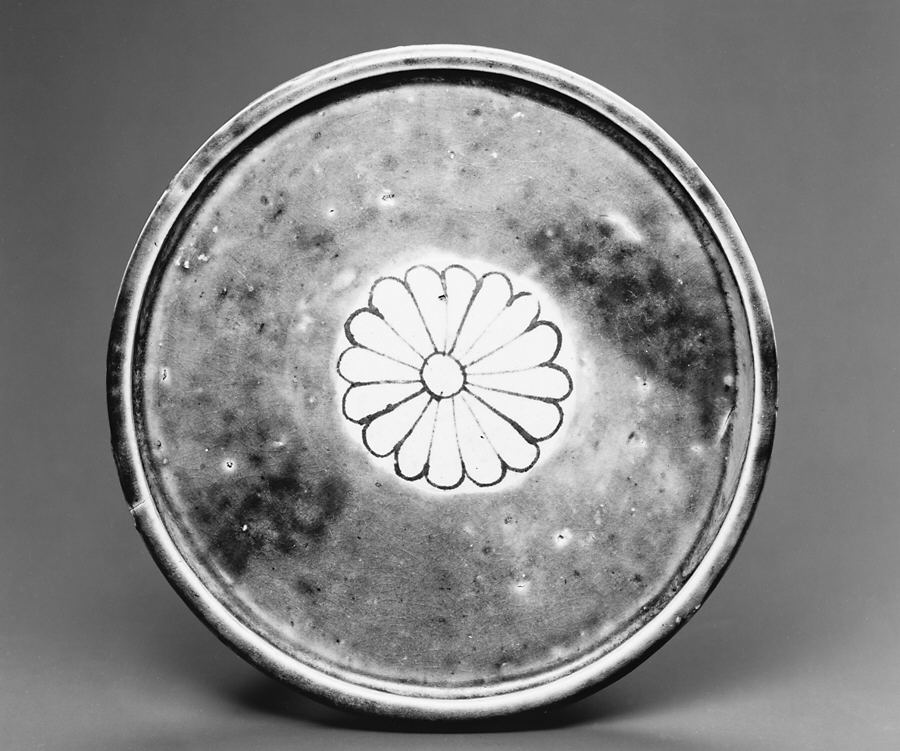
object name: plate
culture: japanese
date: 1800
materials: stoneware